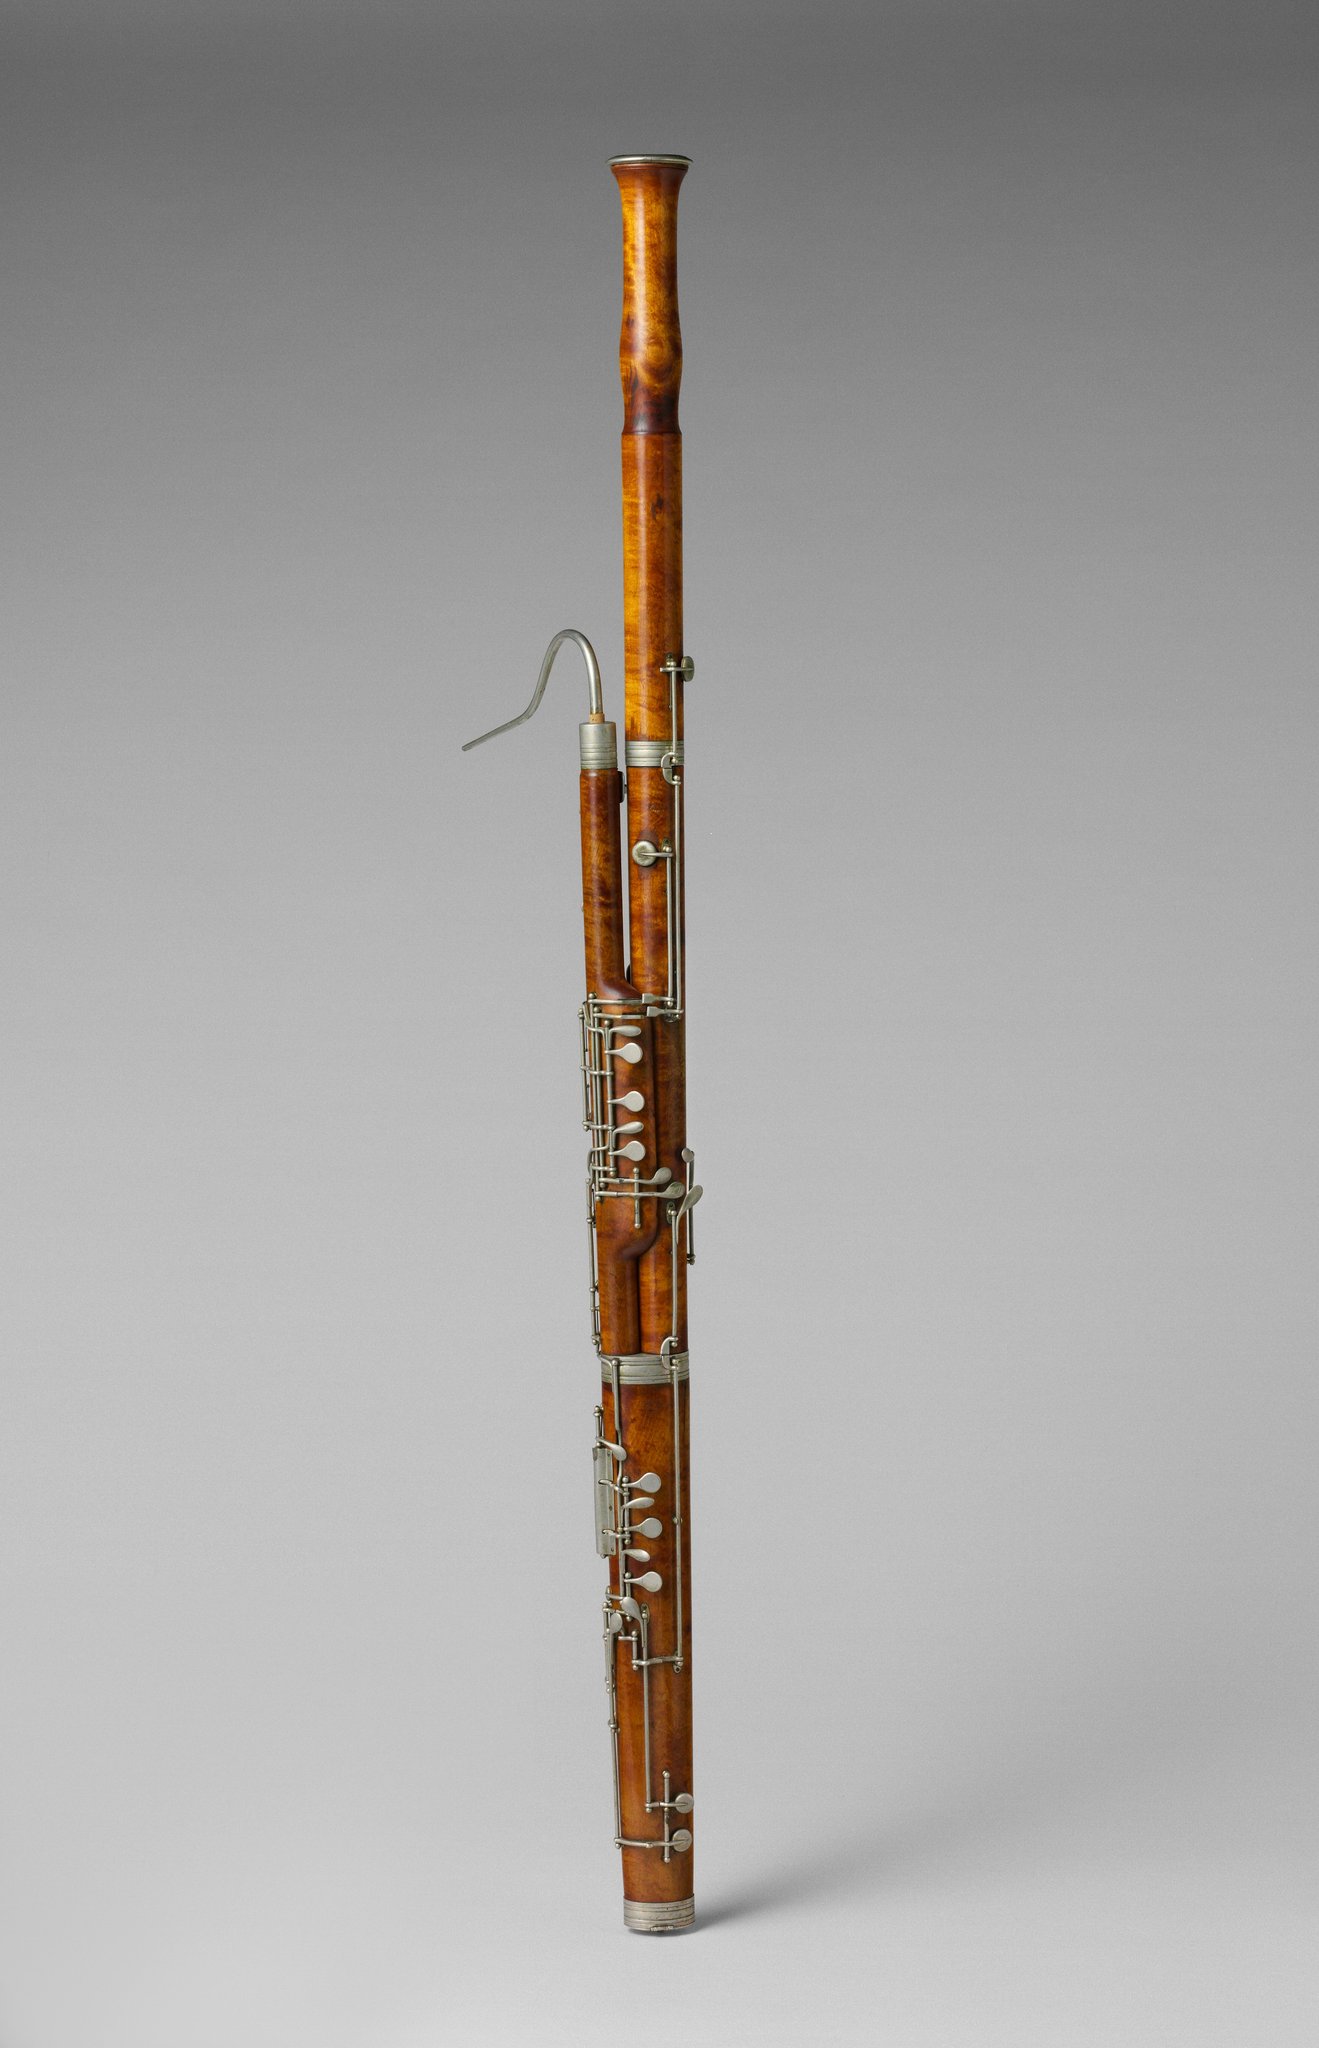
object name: bassoon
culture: italian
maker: giosue esposito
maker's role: maker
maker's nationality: naples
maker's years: 1866-1899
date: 1881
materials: wood, nickel, silver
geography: italy